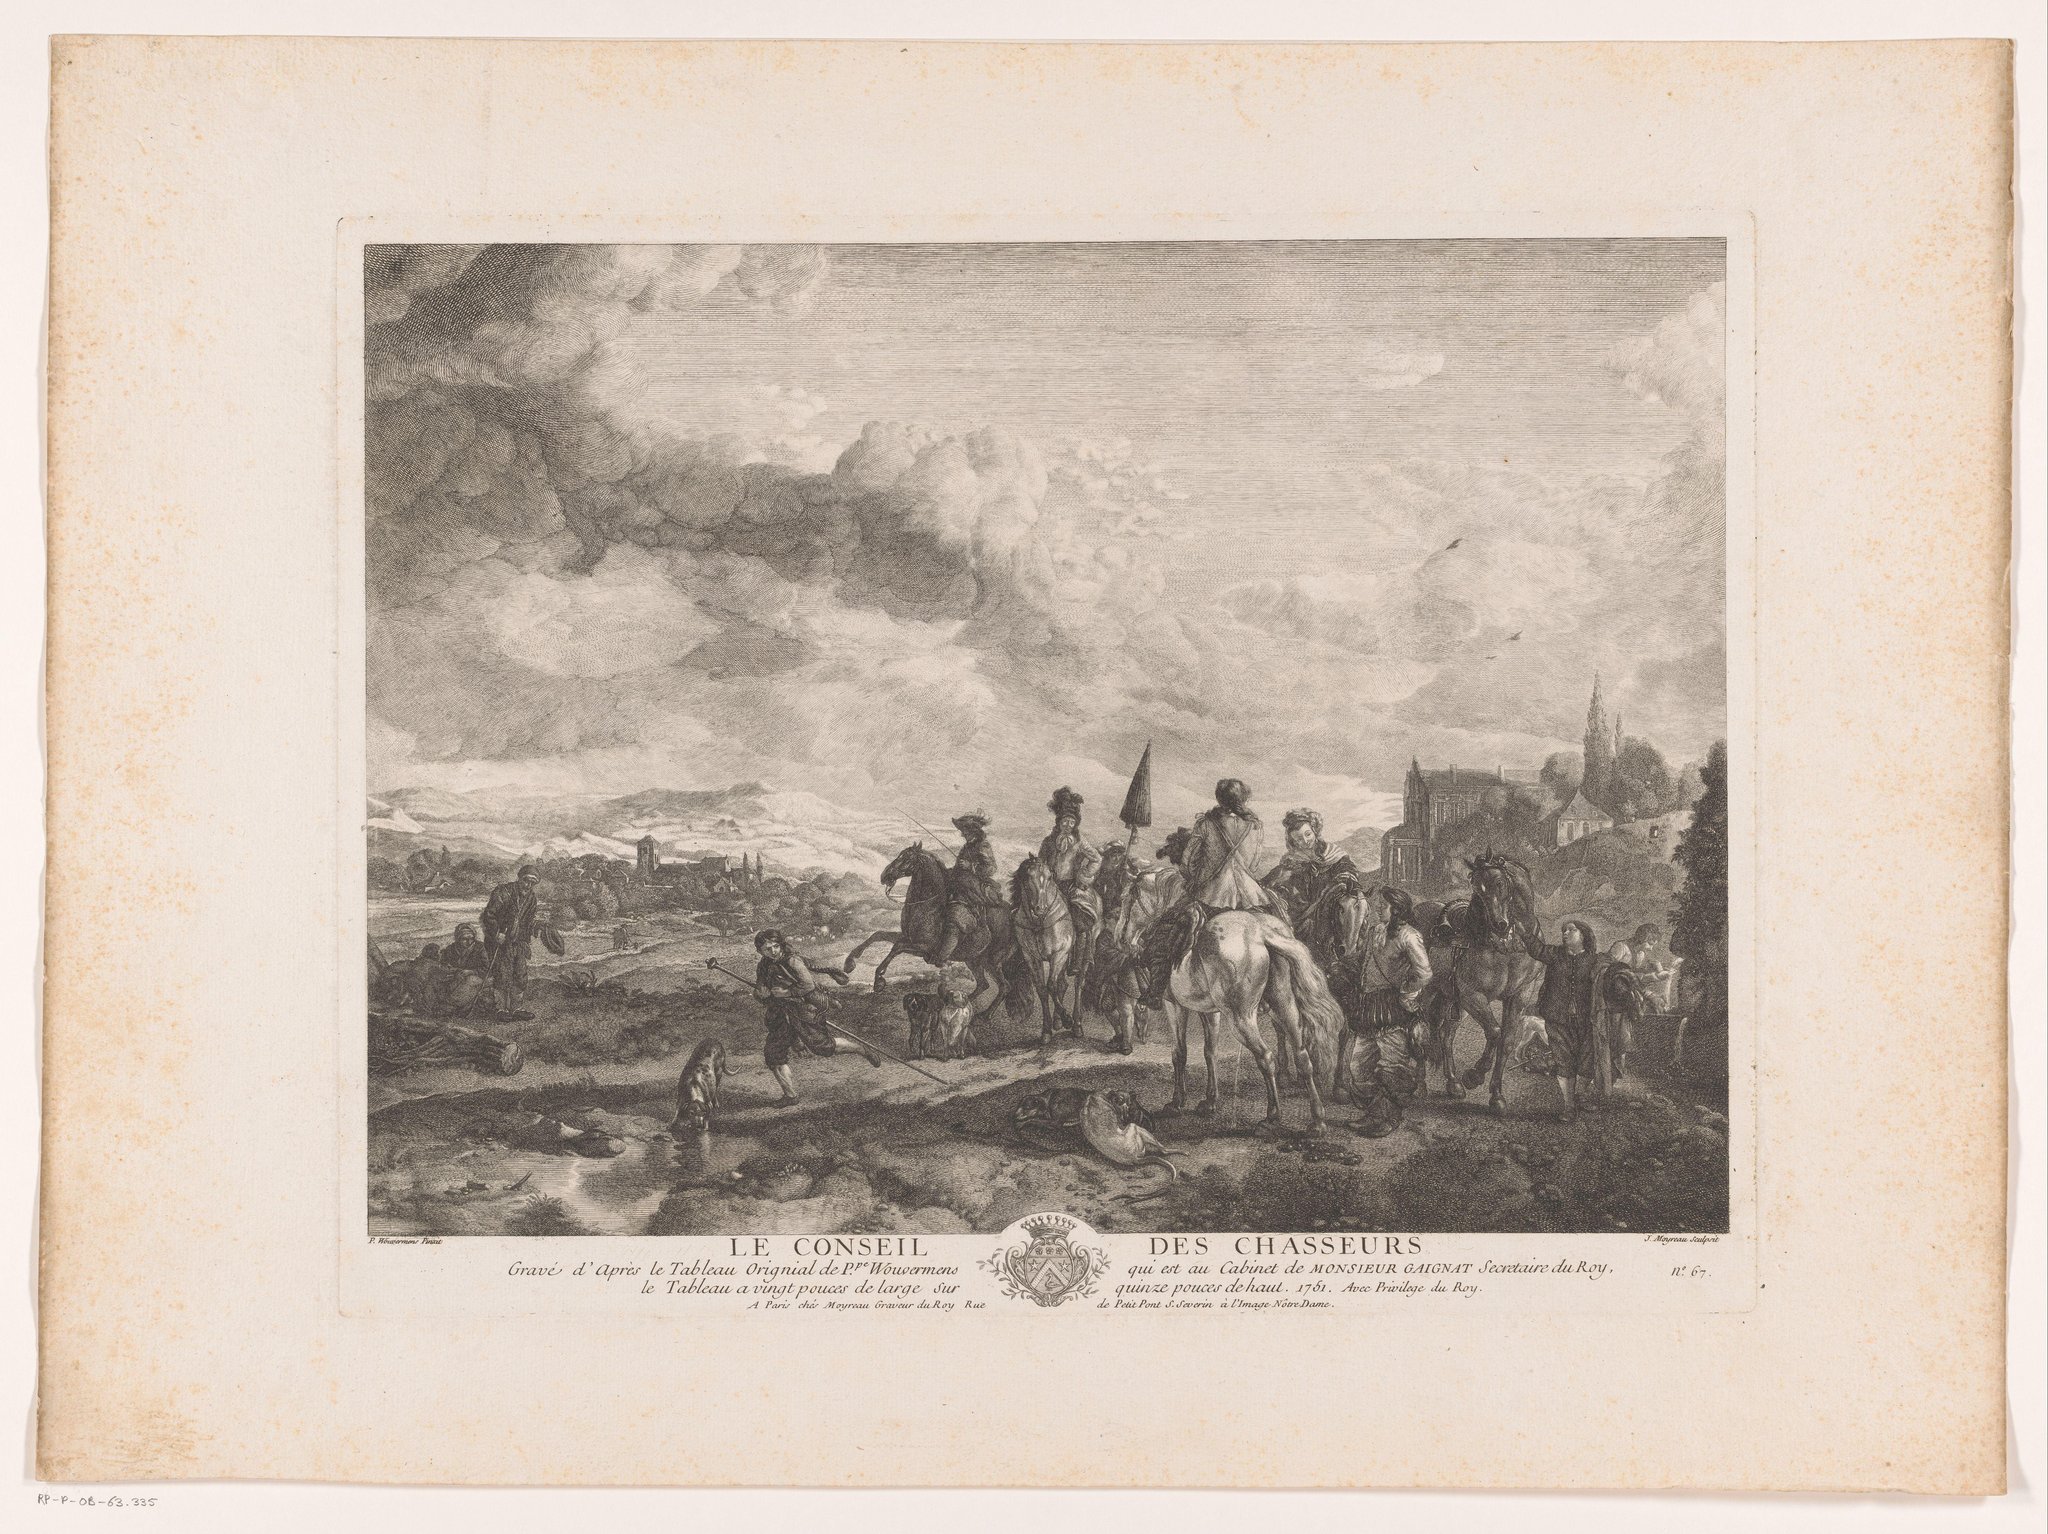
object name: print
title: Le Conseil des Chasseurs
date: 1751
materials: paper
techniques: engraving, etching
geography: france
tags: hunters resting during the hunt, assembling, 'départ pour la chasse'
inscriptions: collector's mark: Lugt 240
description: Maakt deel uit van een serie van 89 prenten te dateren tussen ca. 1733-1762, naar het geschilderde oeuvre van Philips Wouwerman. Dit betreft plaat 67.